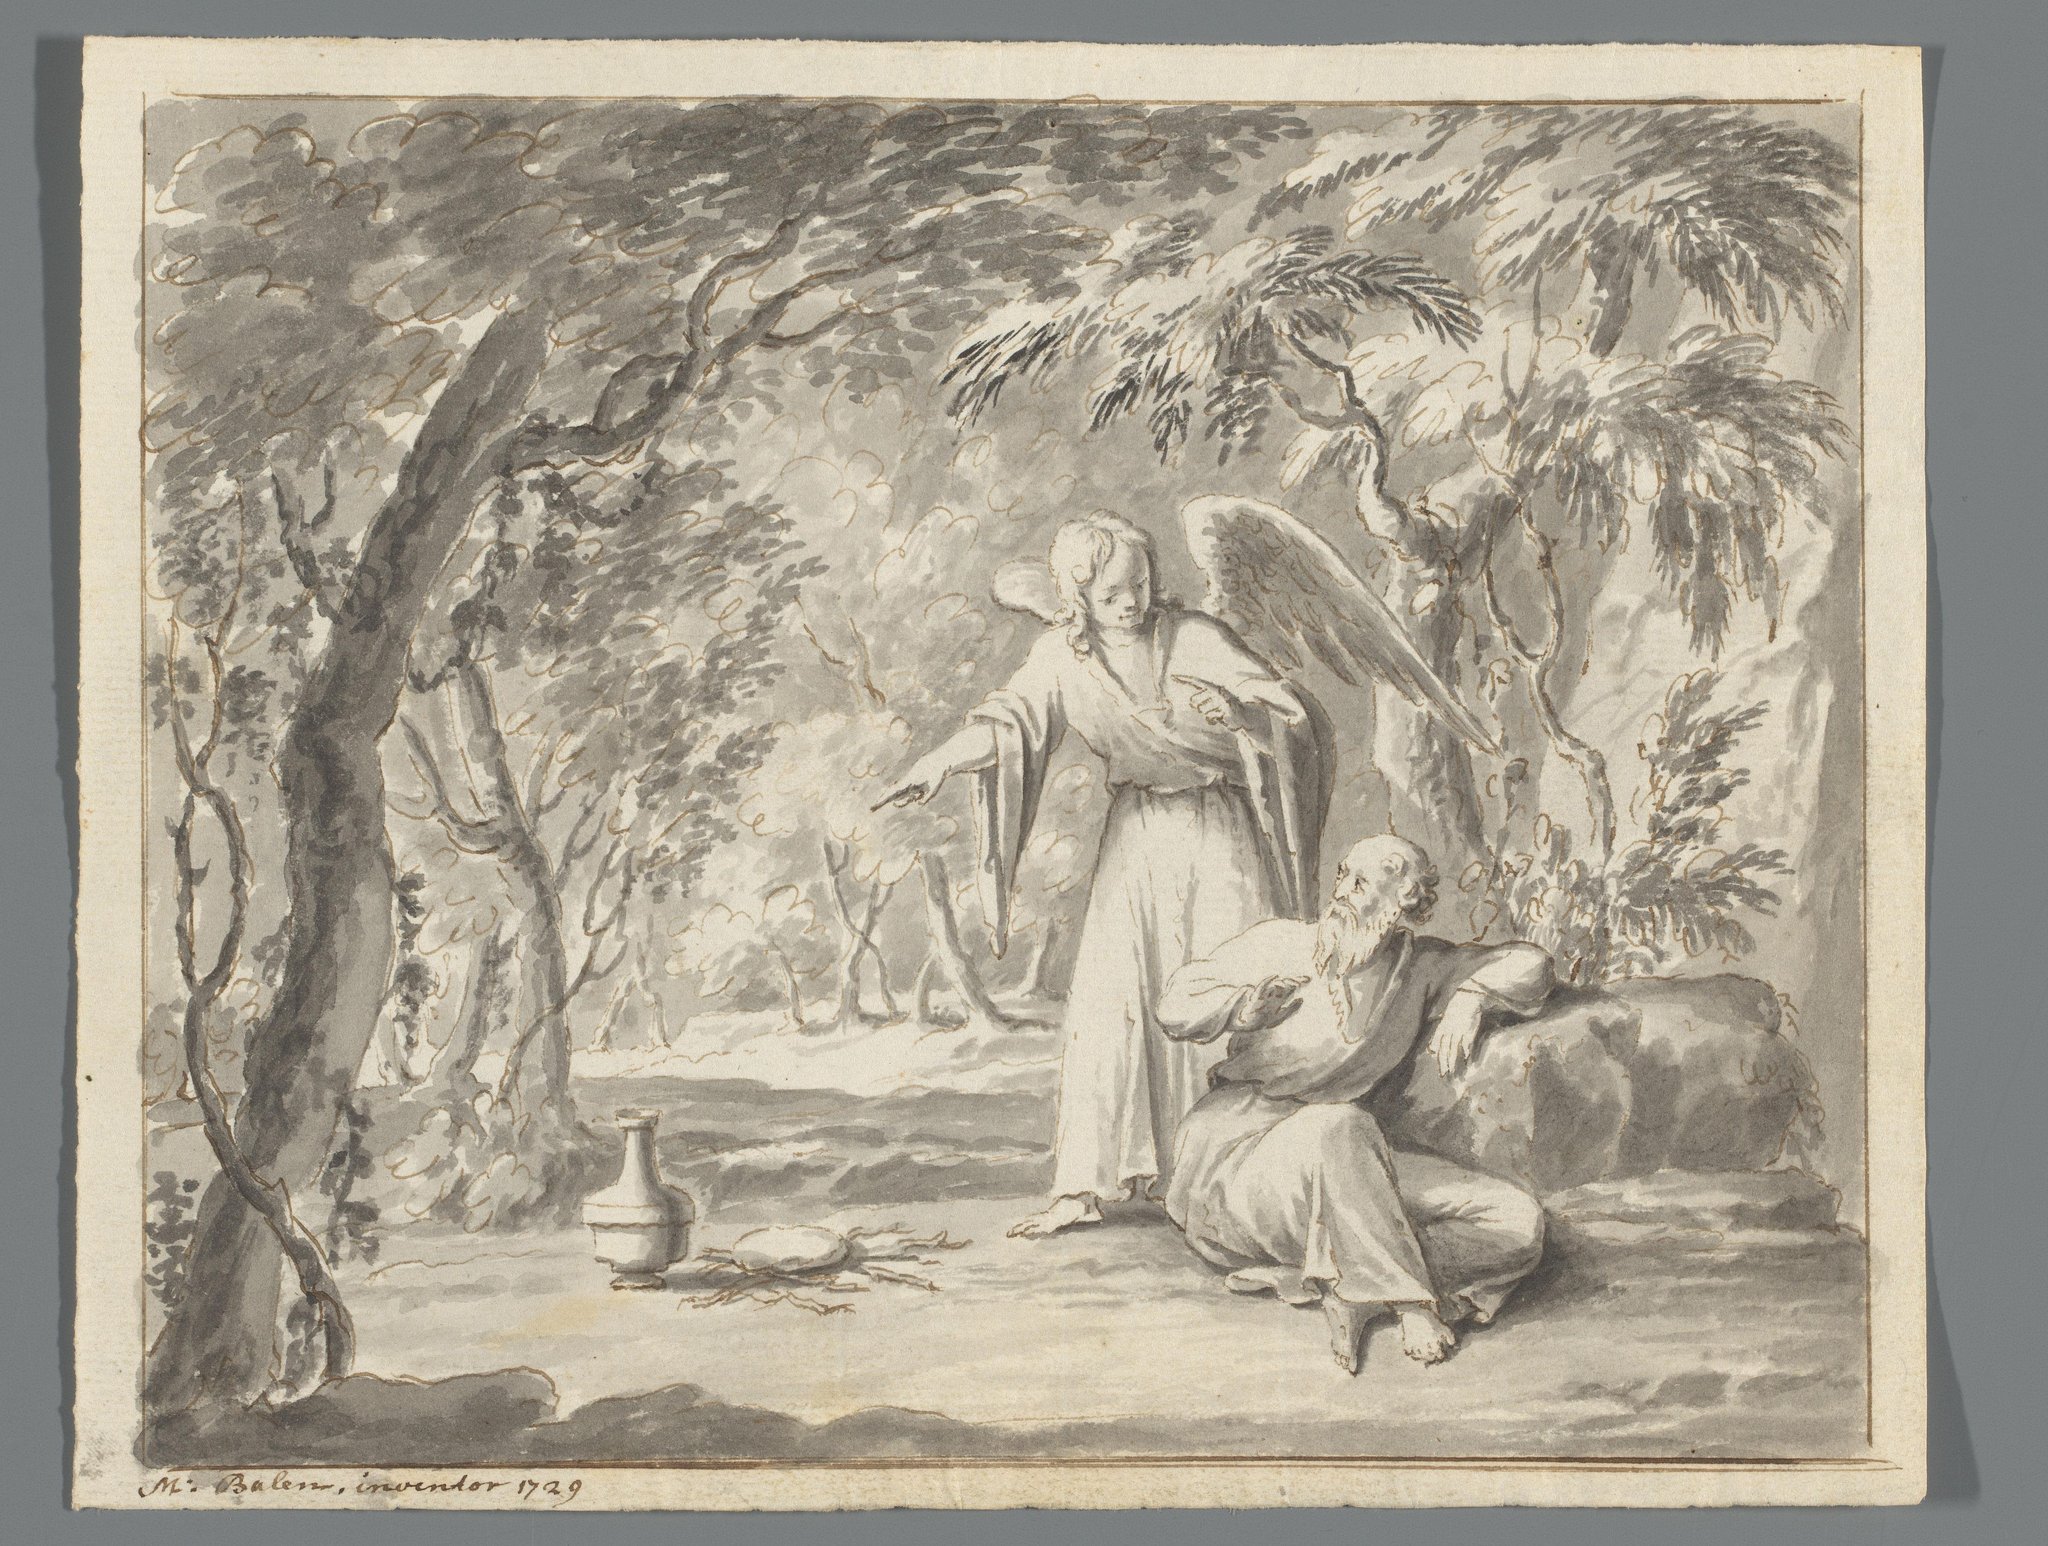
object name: drawing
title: Elia en de engel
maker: matthijs balen (1684-1766)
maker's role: draughtsman, painter, print maker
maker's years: 1684-1766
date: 1729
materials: paper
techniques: brush, pen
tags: an angel wakes elijah; a loaf of bread and a jar of water are usually at elijah's head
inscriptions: date